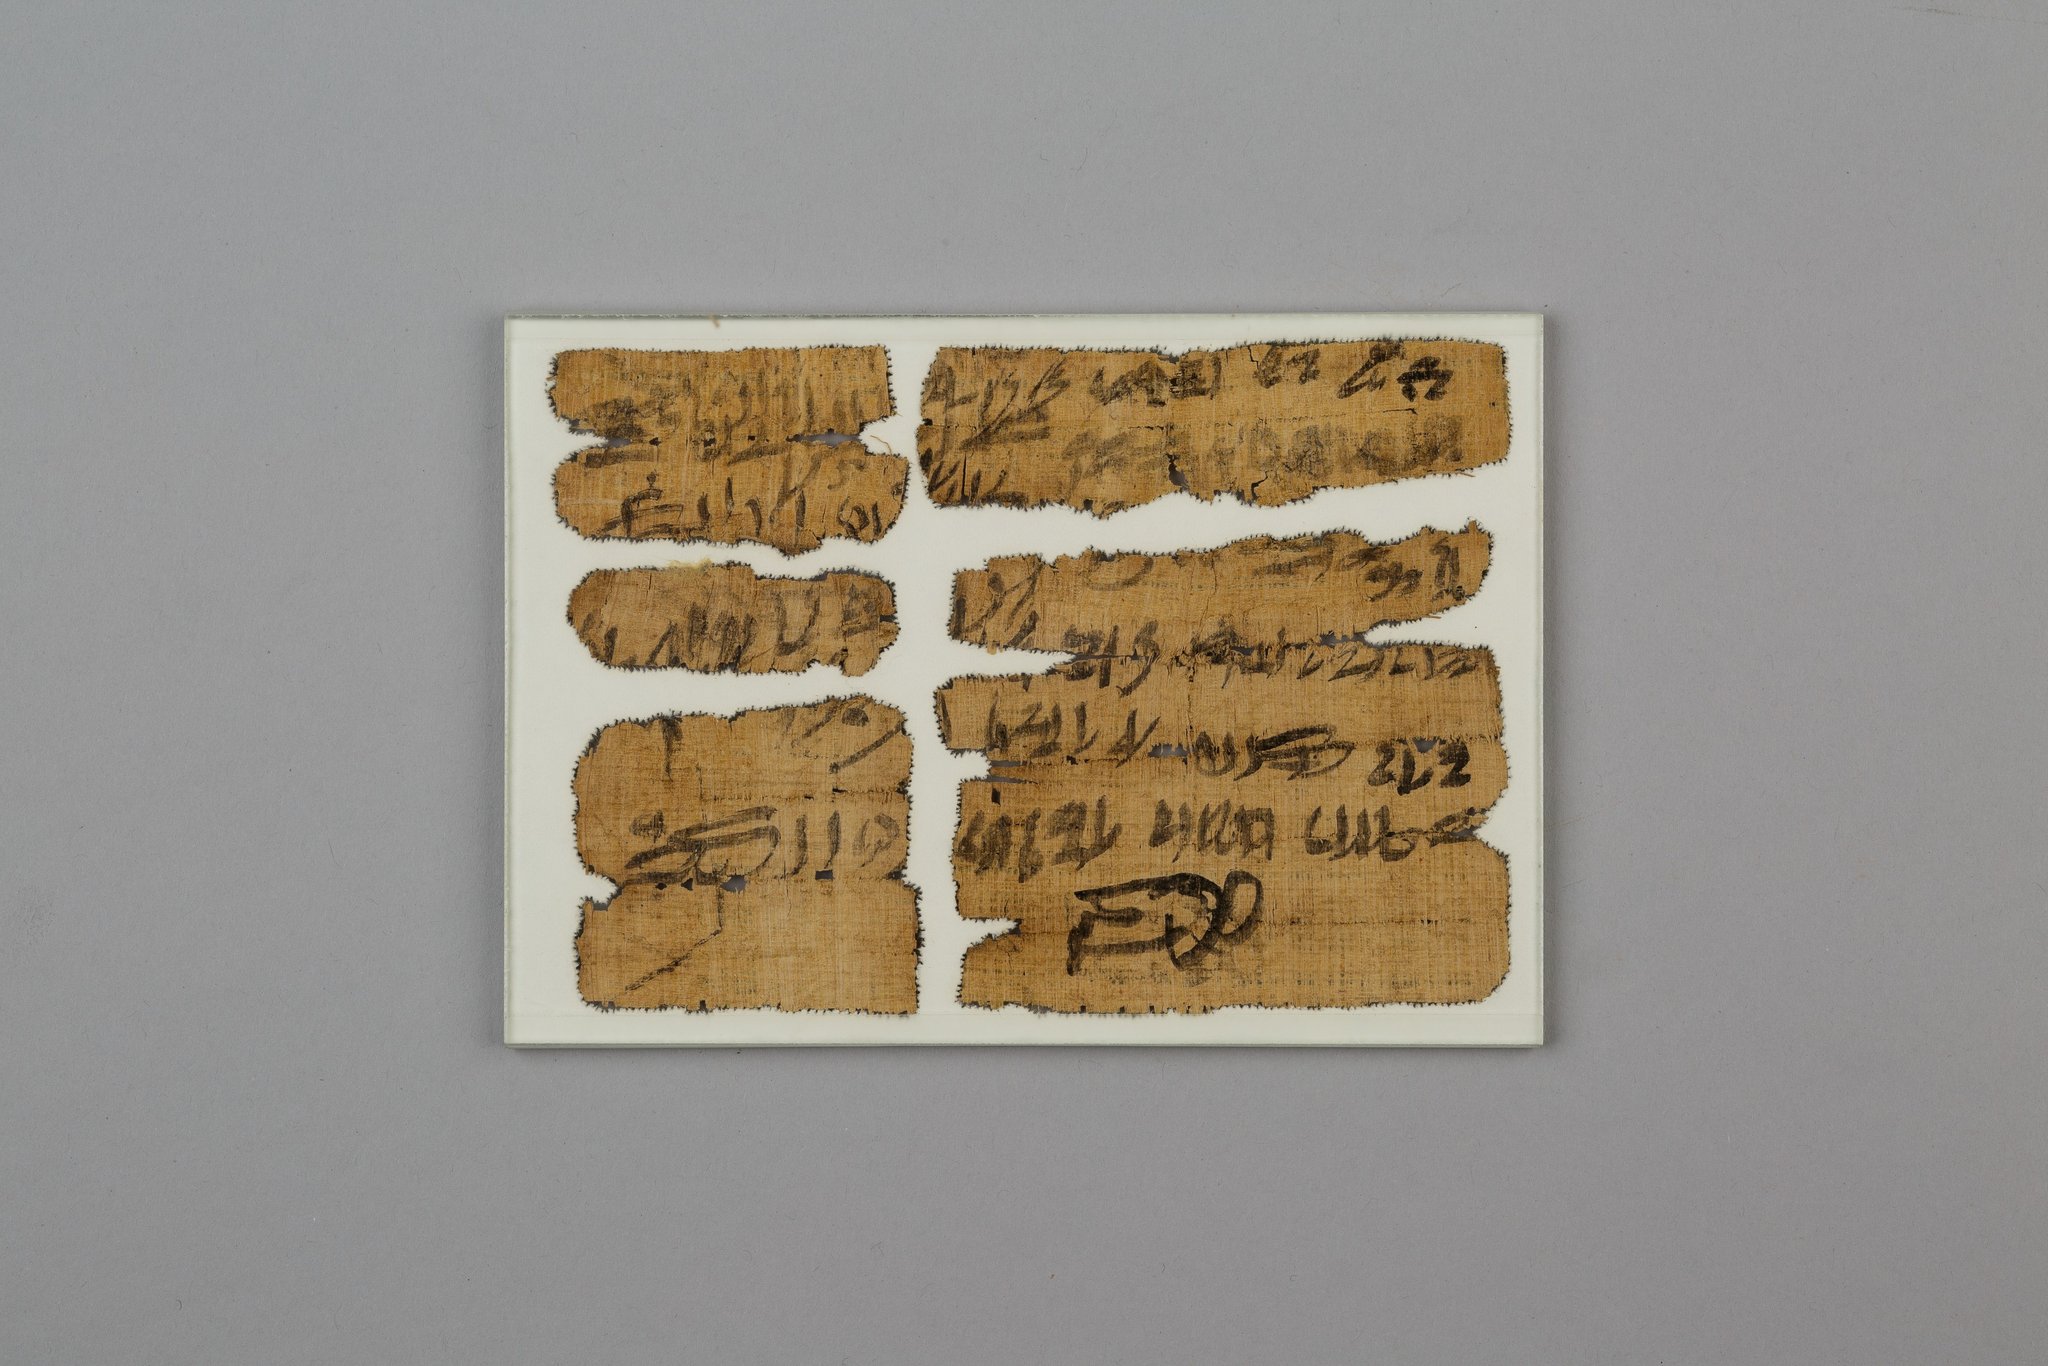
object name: papyrus, charm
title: Papyrus charm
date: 664-525 BCE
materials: ink, papyrus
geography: egypt